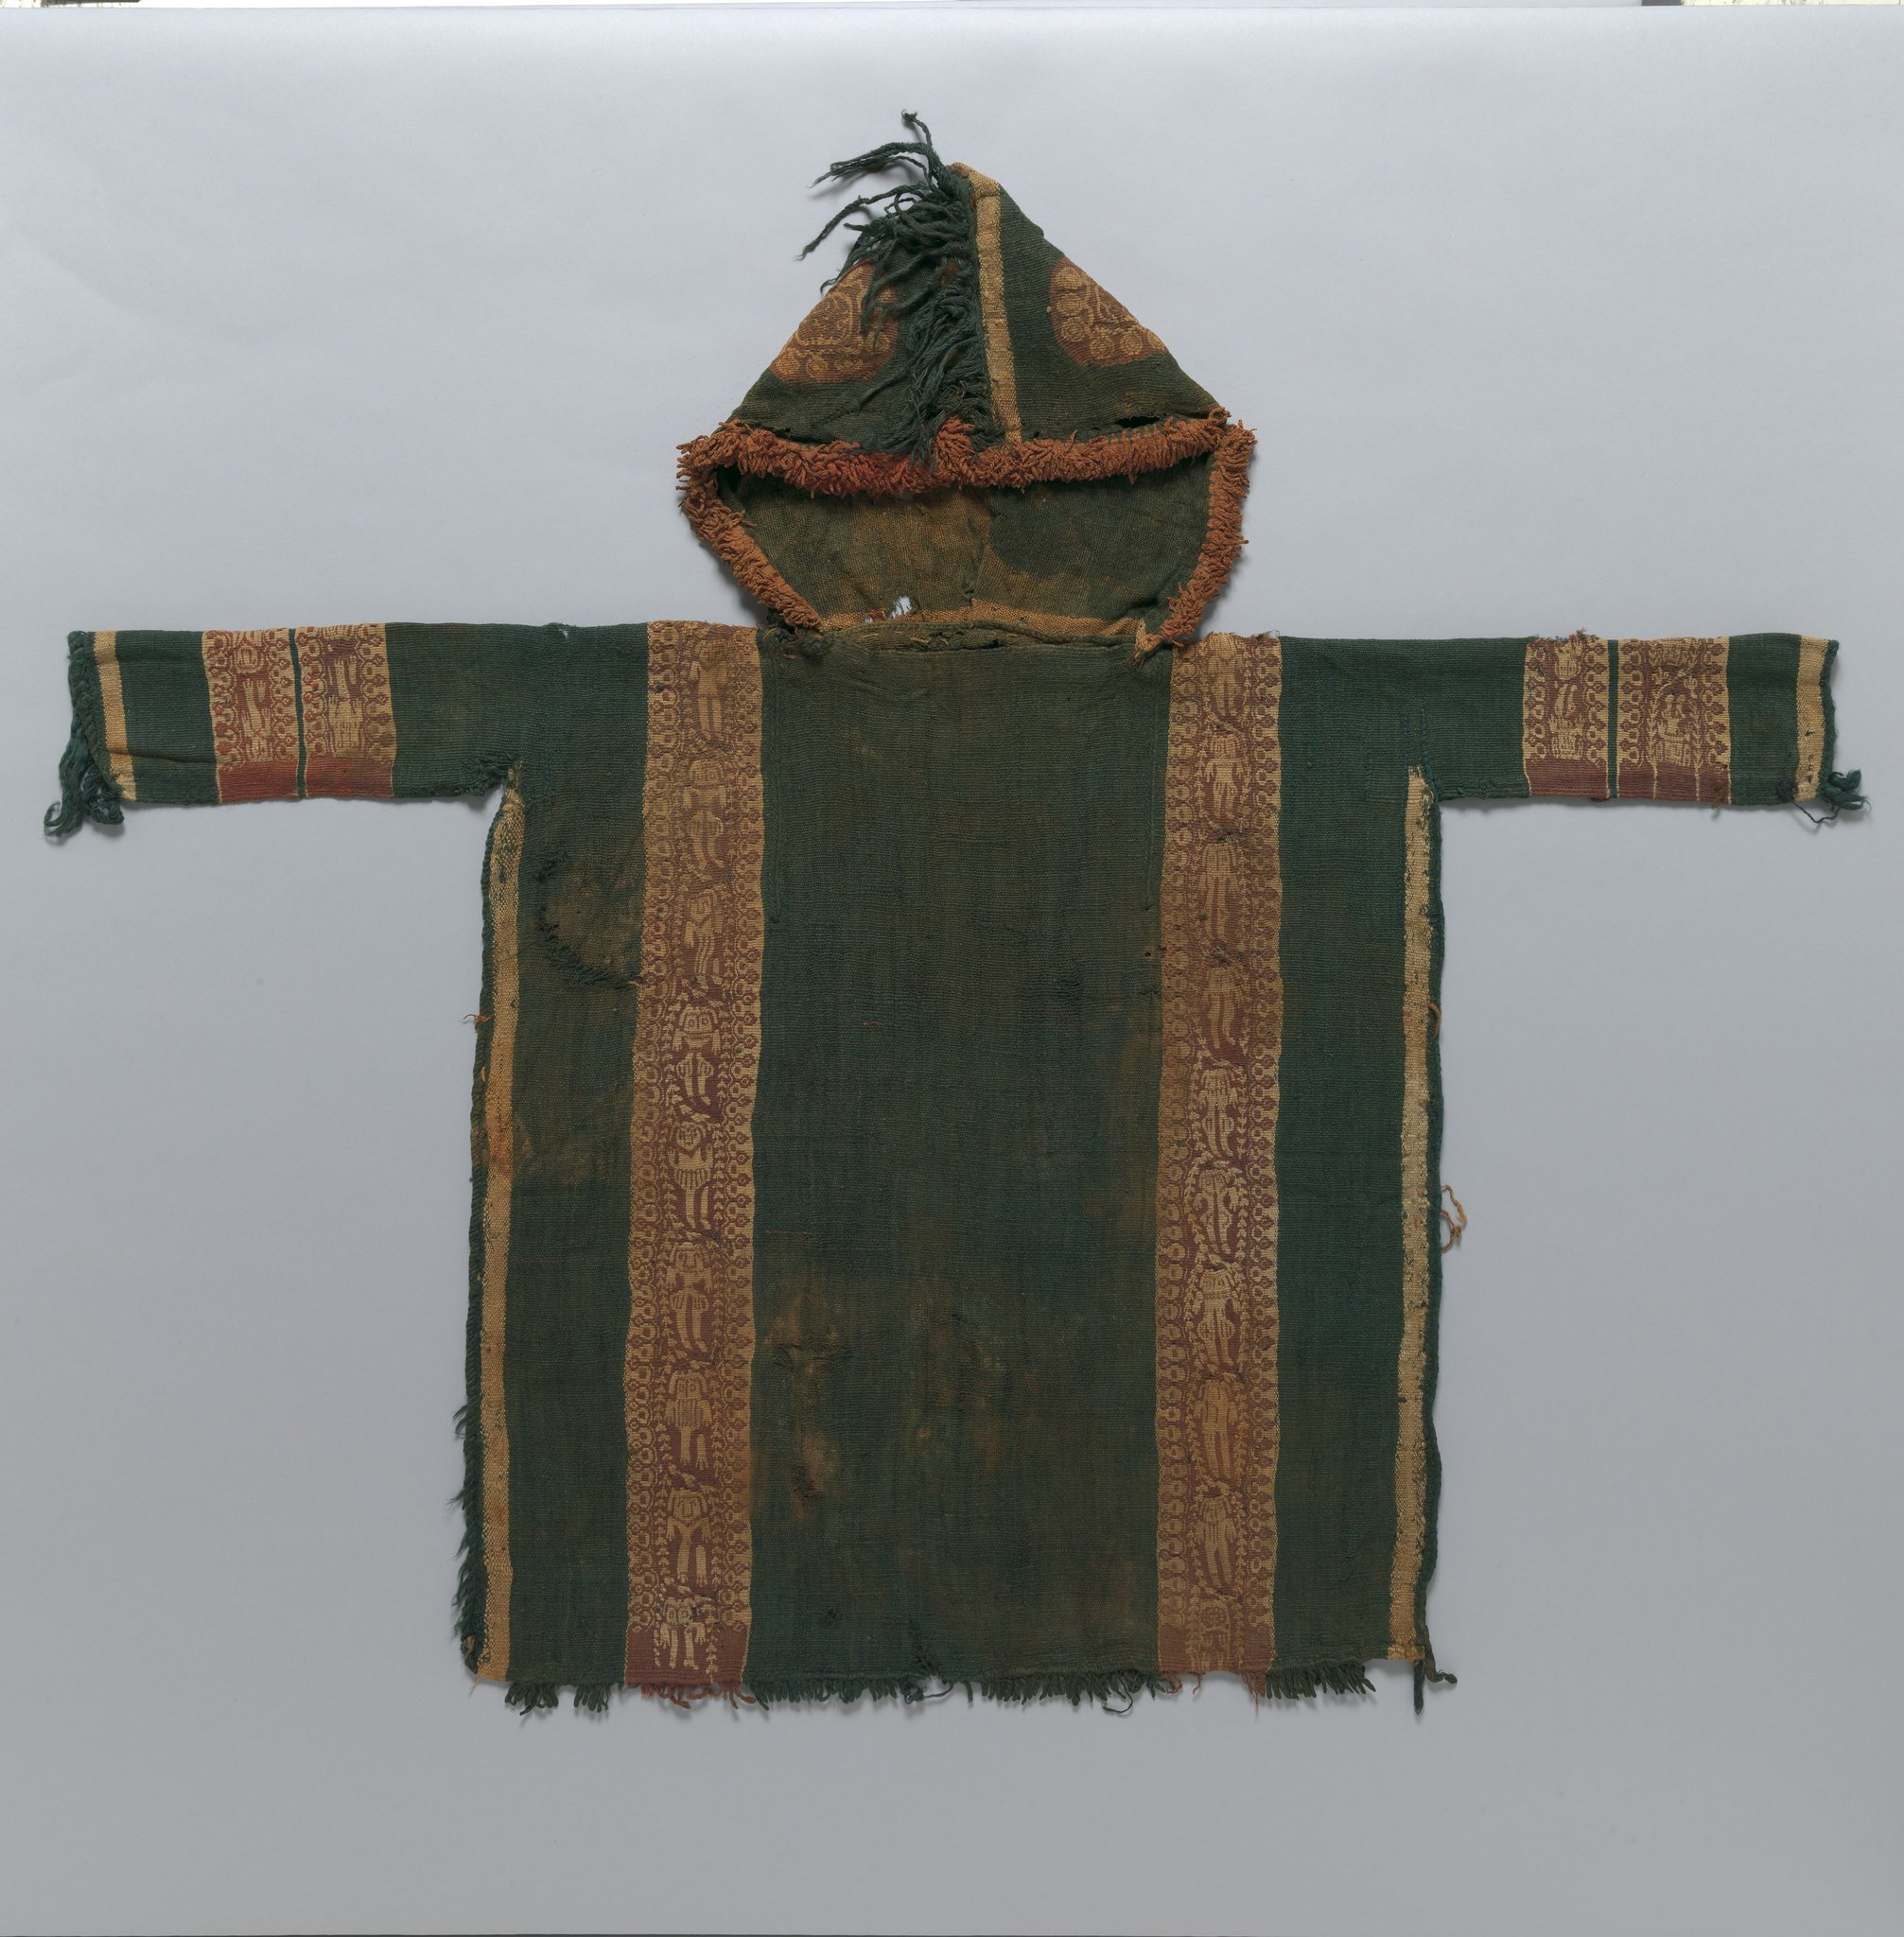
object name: tunic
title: Child's Tunic with Hood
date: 600-900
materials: wool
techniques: weave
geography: egypt